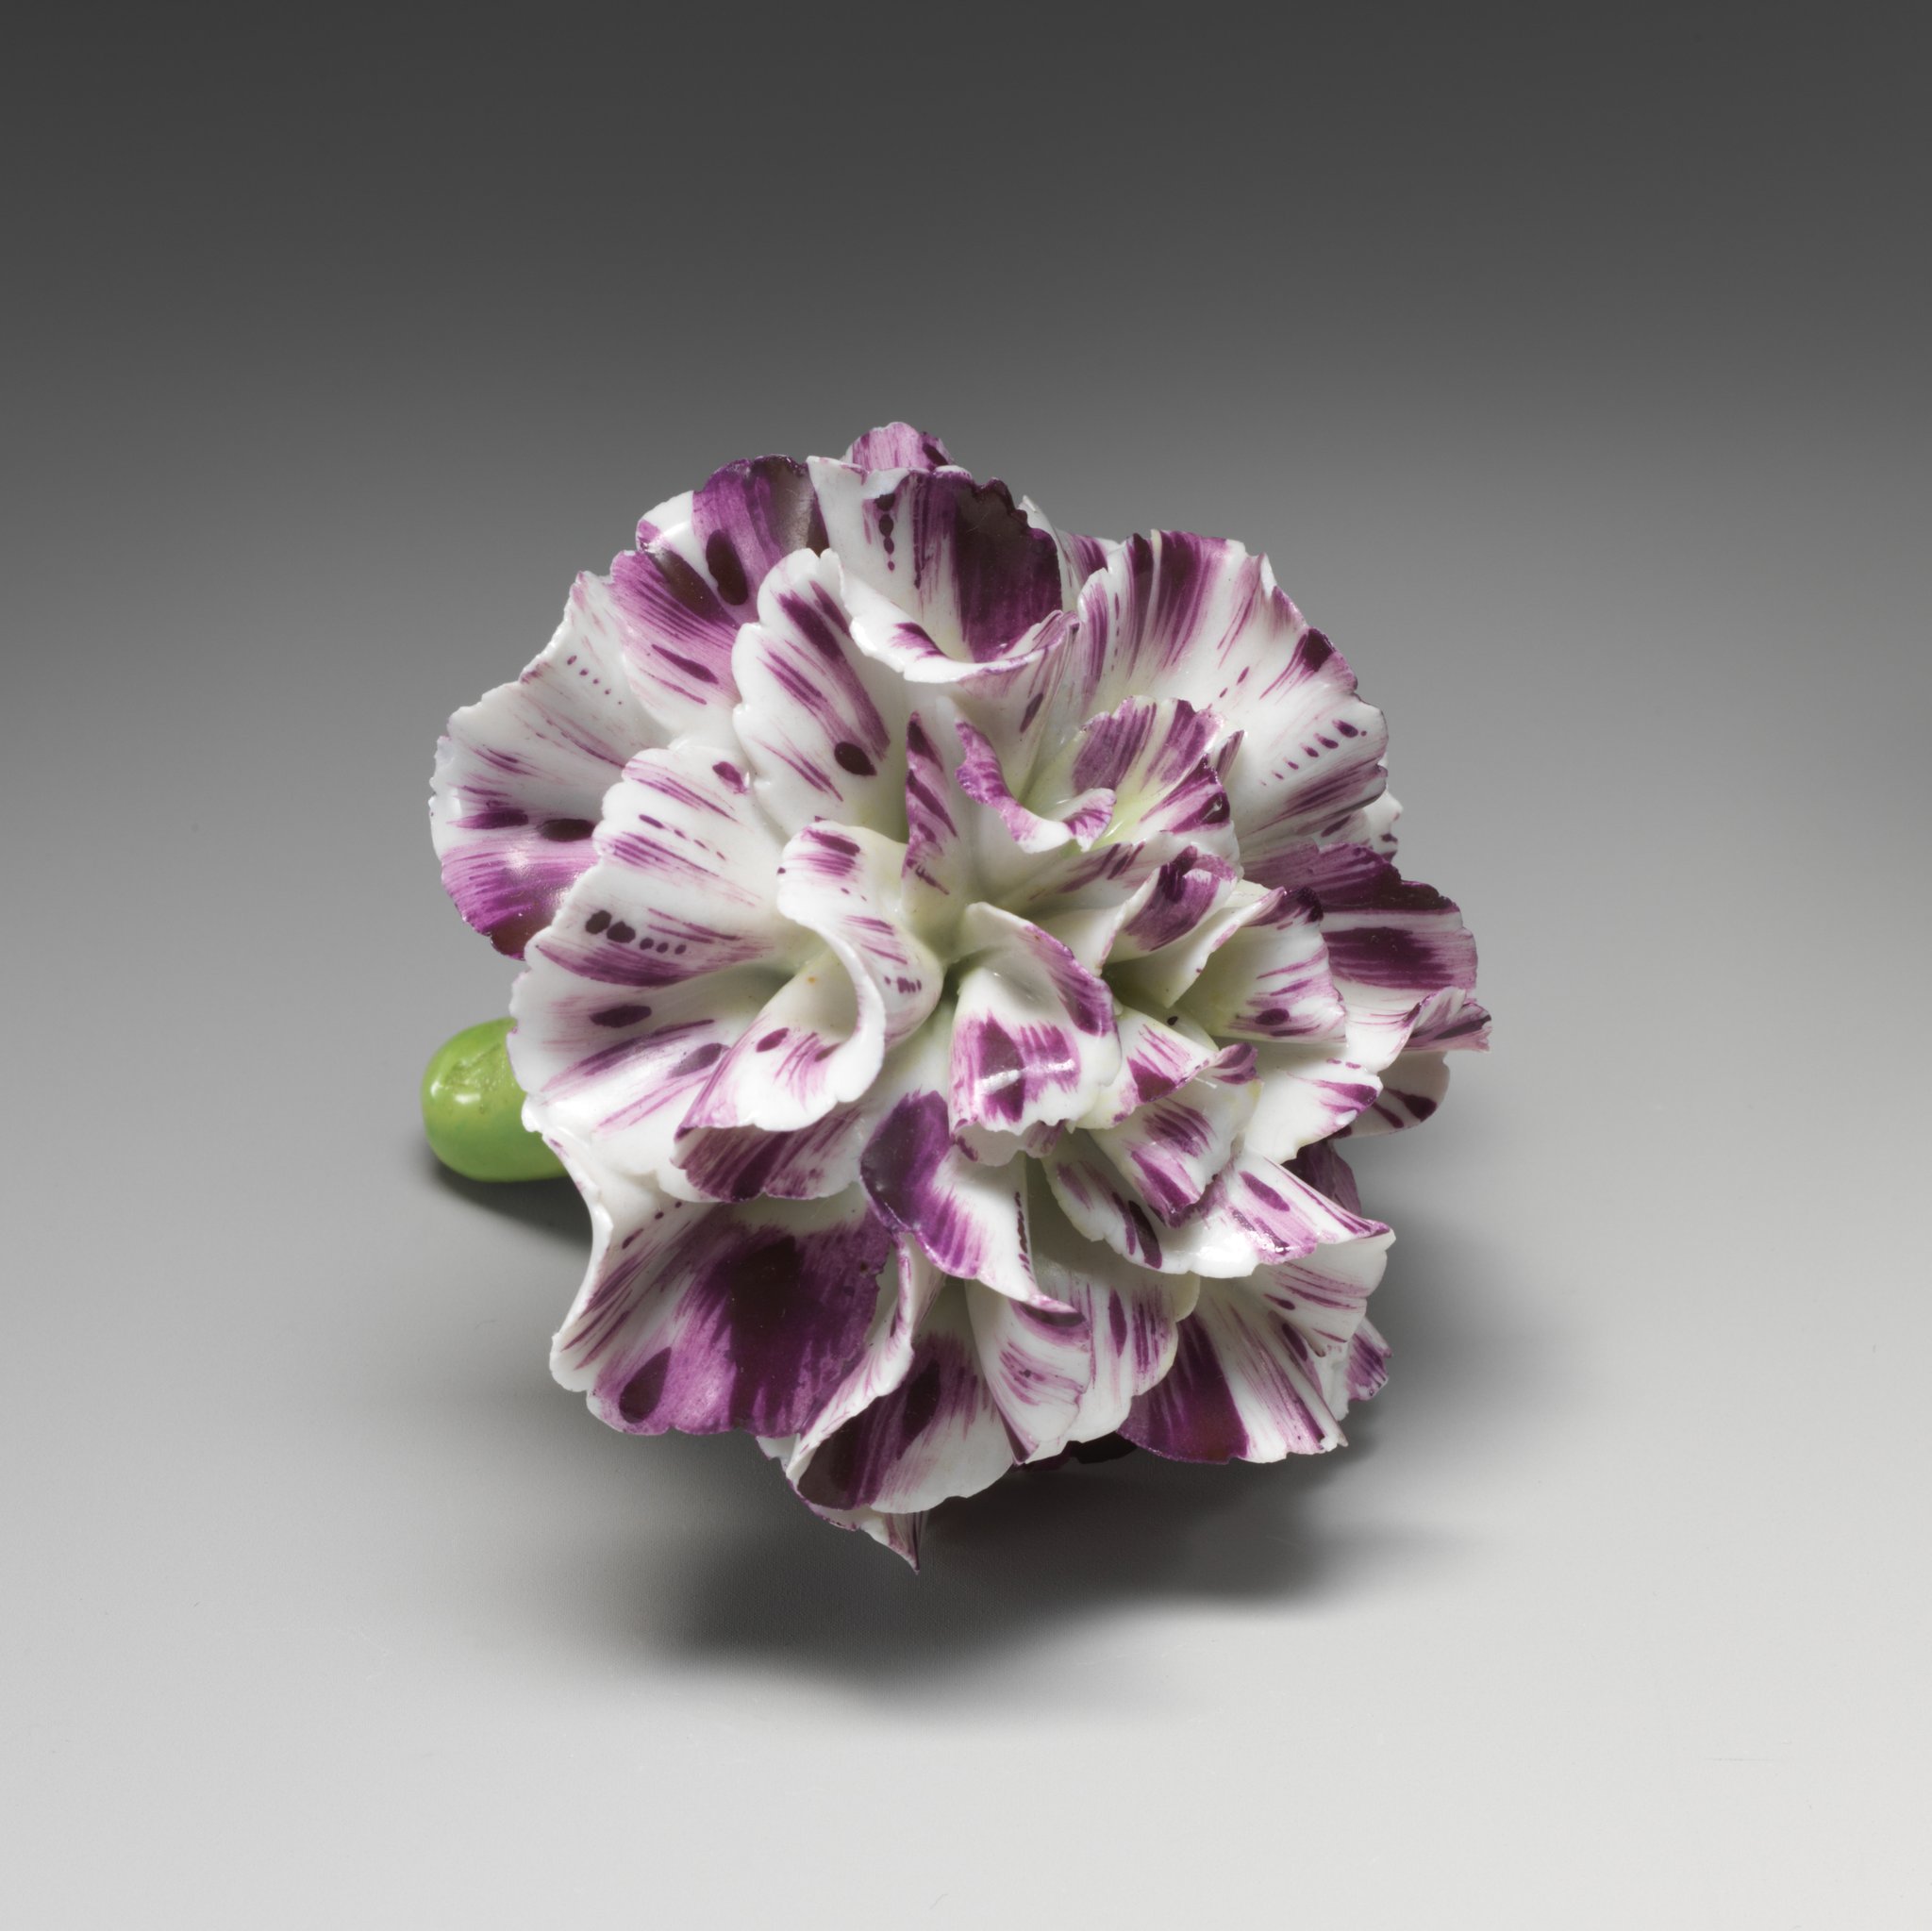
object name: flower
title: Porcelain flower (one of a set of nine)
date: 1734-1766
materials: soft paste porcelain